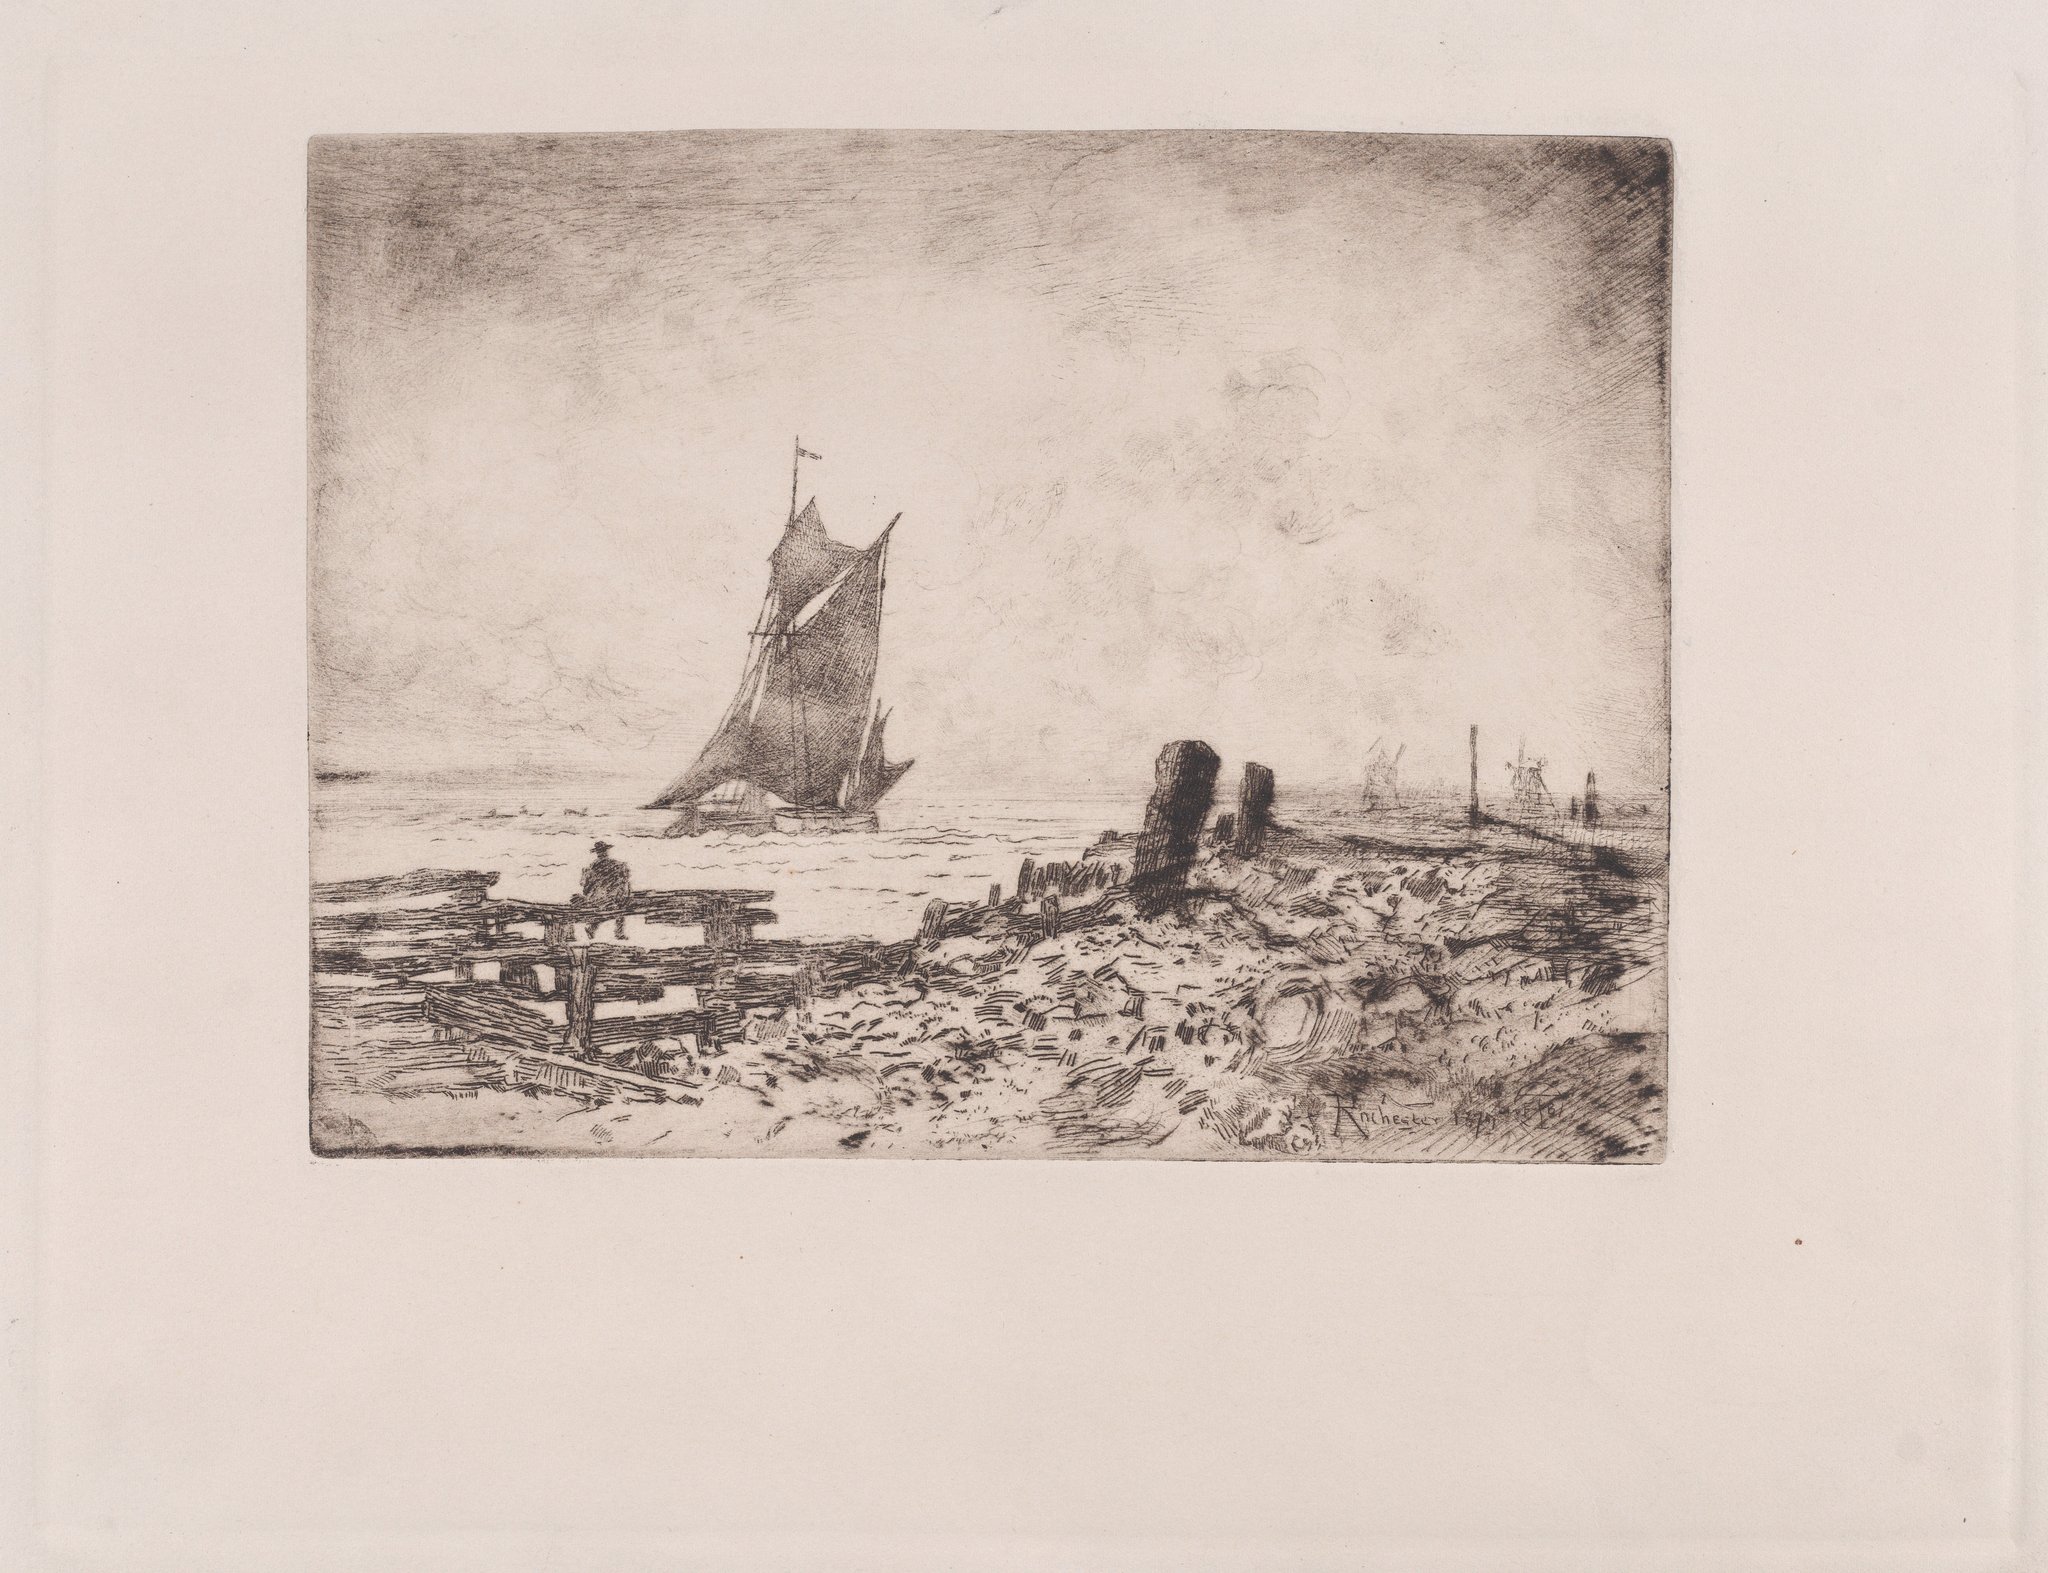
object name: print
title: The Little Marine -- Souvenir of Medway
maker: félix-hilaire buhot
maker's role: artist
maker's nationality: french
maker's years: 1847-1898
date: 1879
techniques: etching